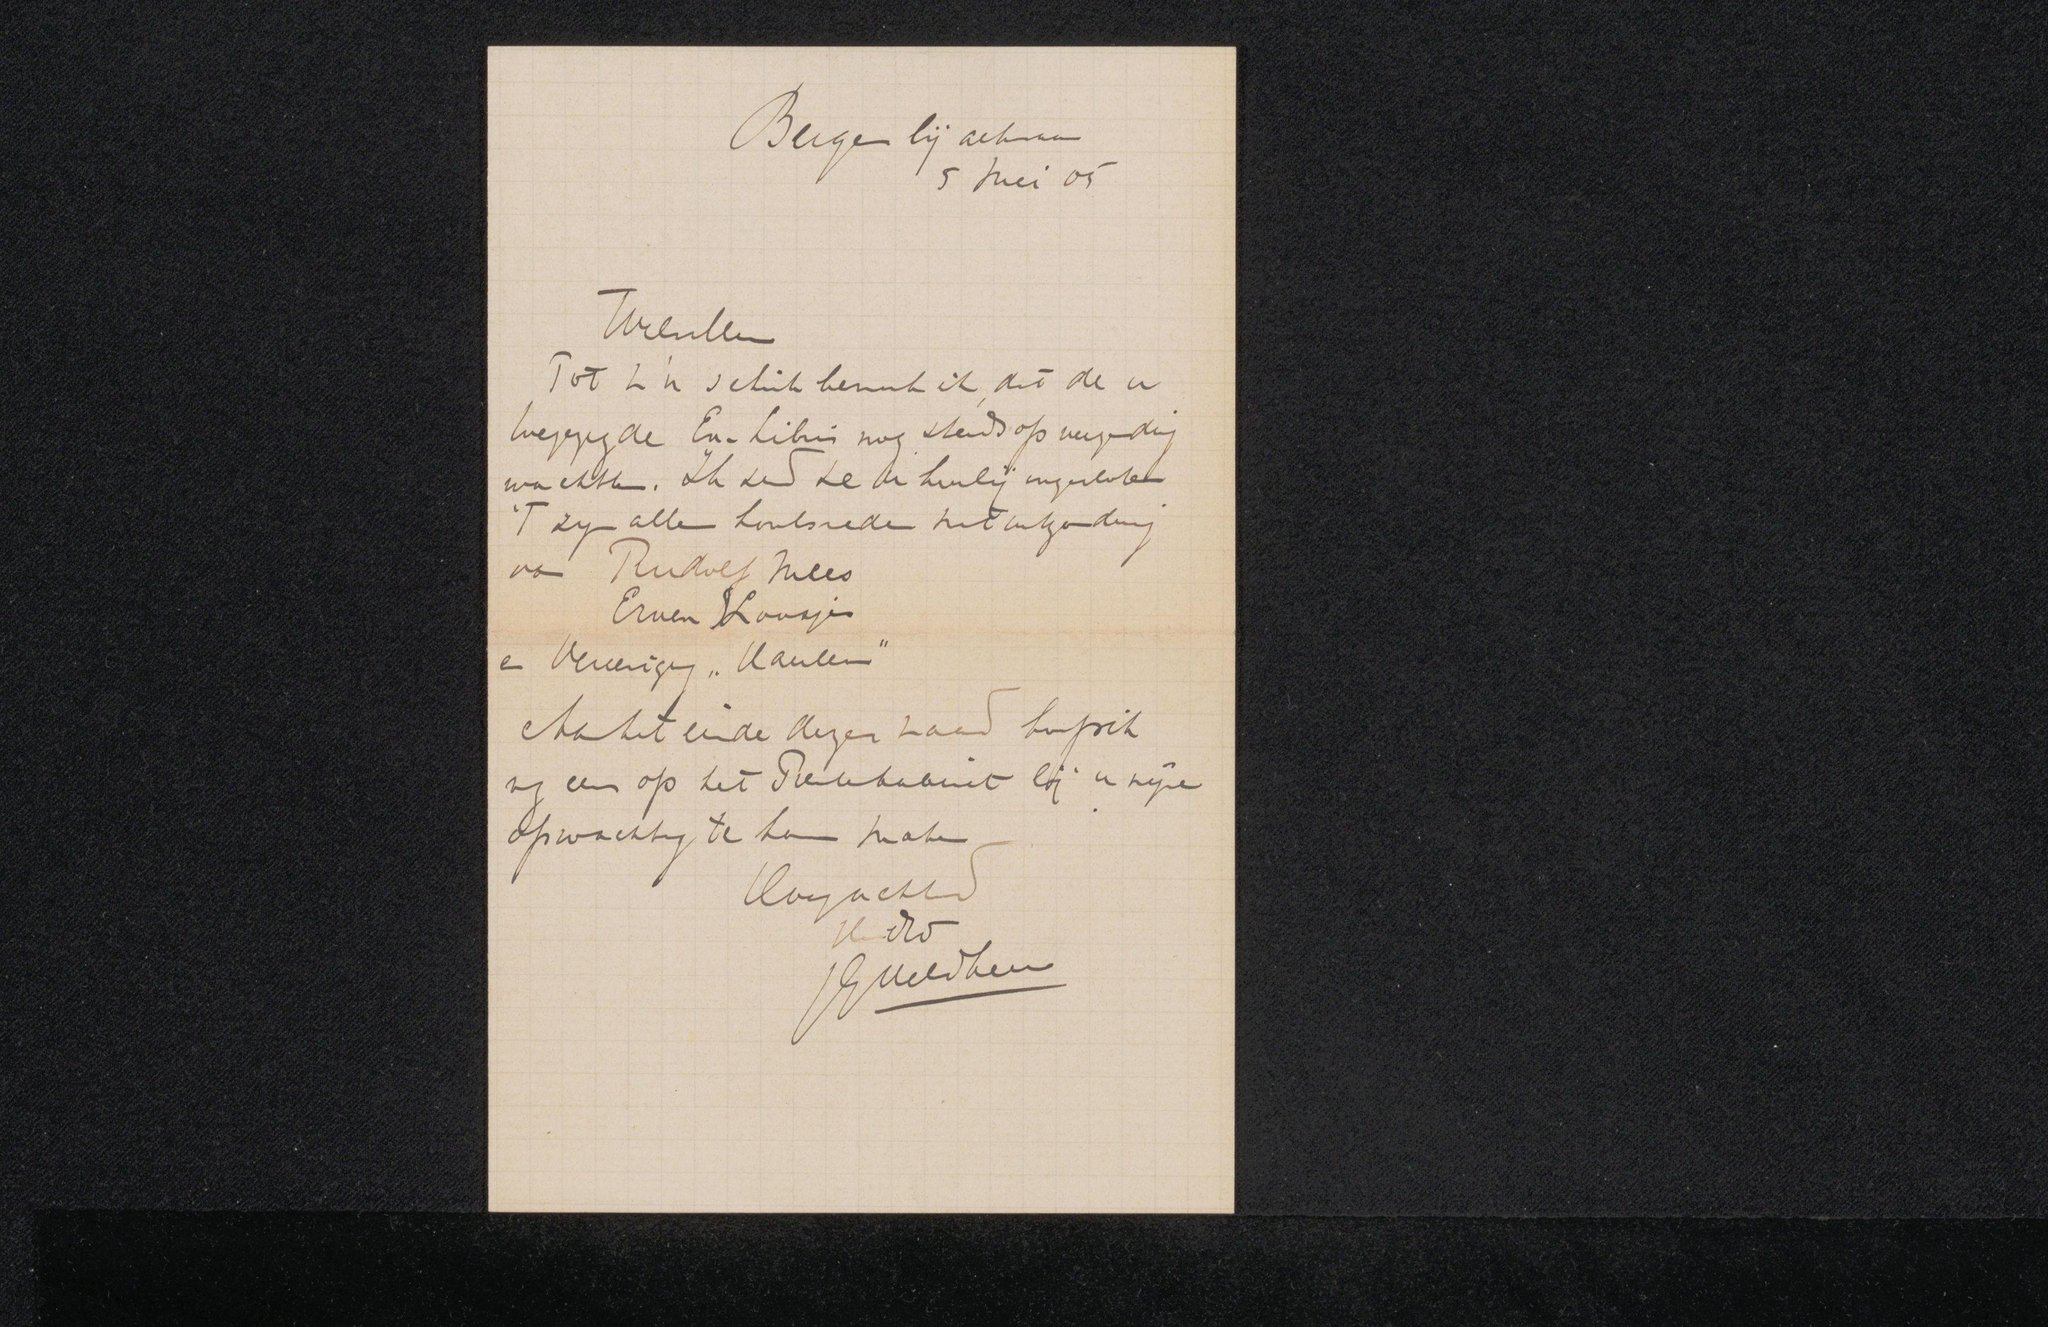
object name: letter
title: Brief aan anoniem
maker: jacobus gerardus veldheer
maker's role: draughtsman, print maker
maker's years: 1866-1954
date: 1905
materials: ink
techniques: pen, writing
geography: bergen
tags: rotterdam, print room, the graphic arts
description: De ex libris onder gerelateerd object worden genoemd in de brief.